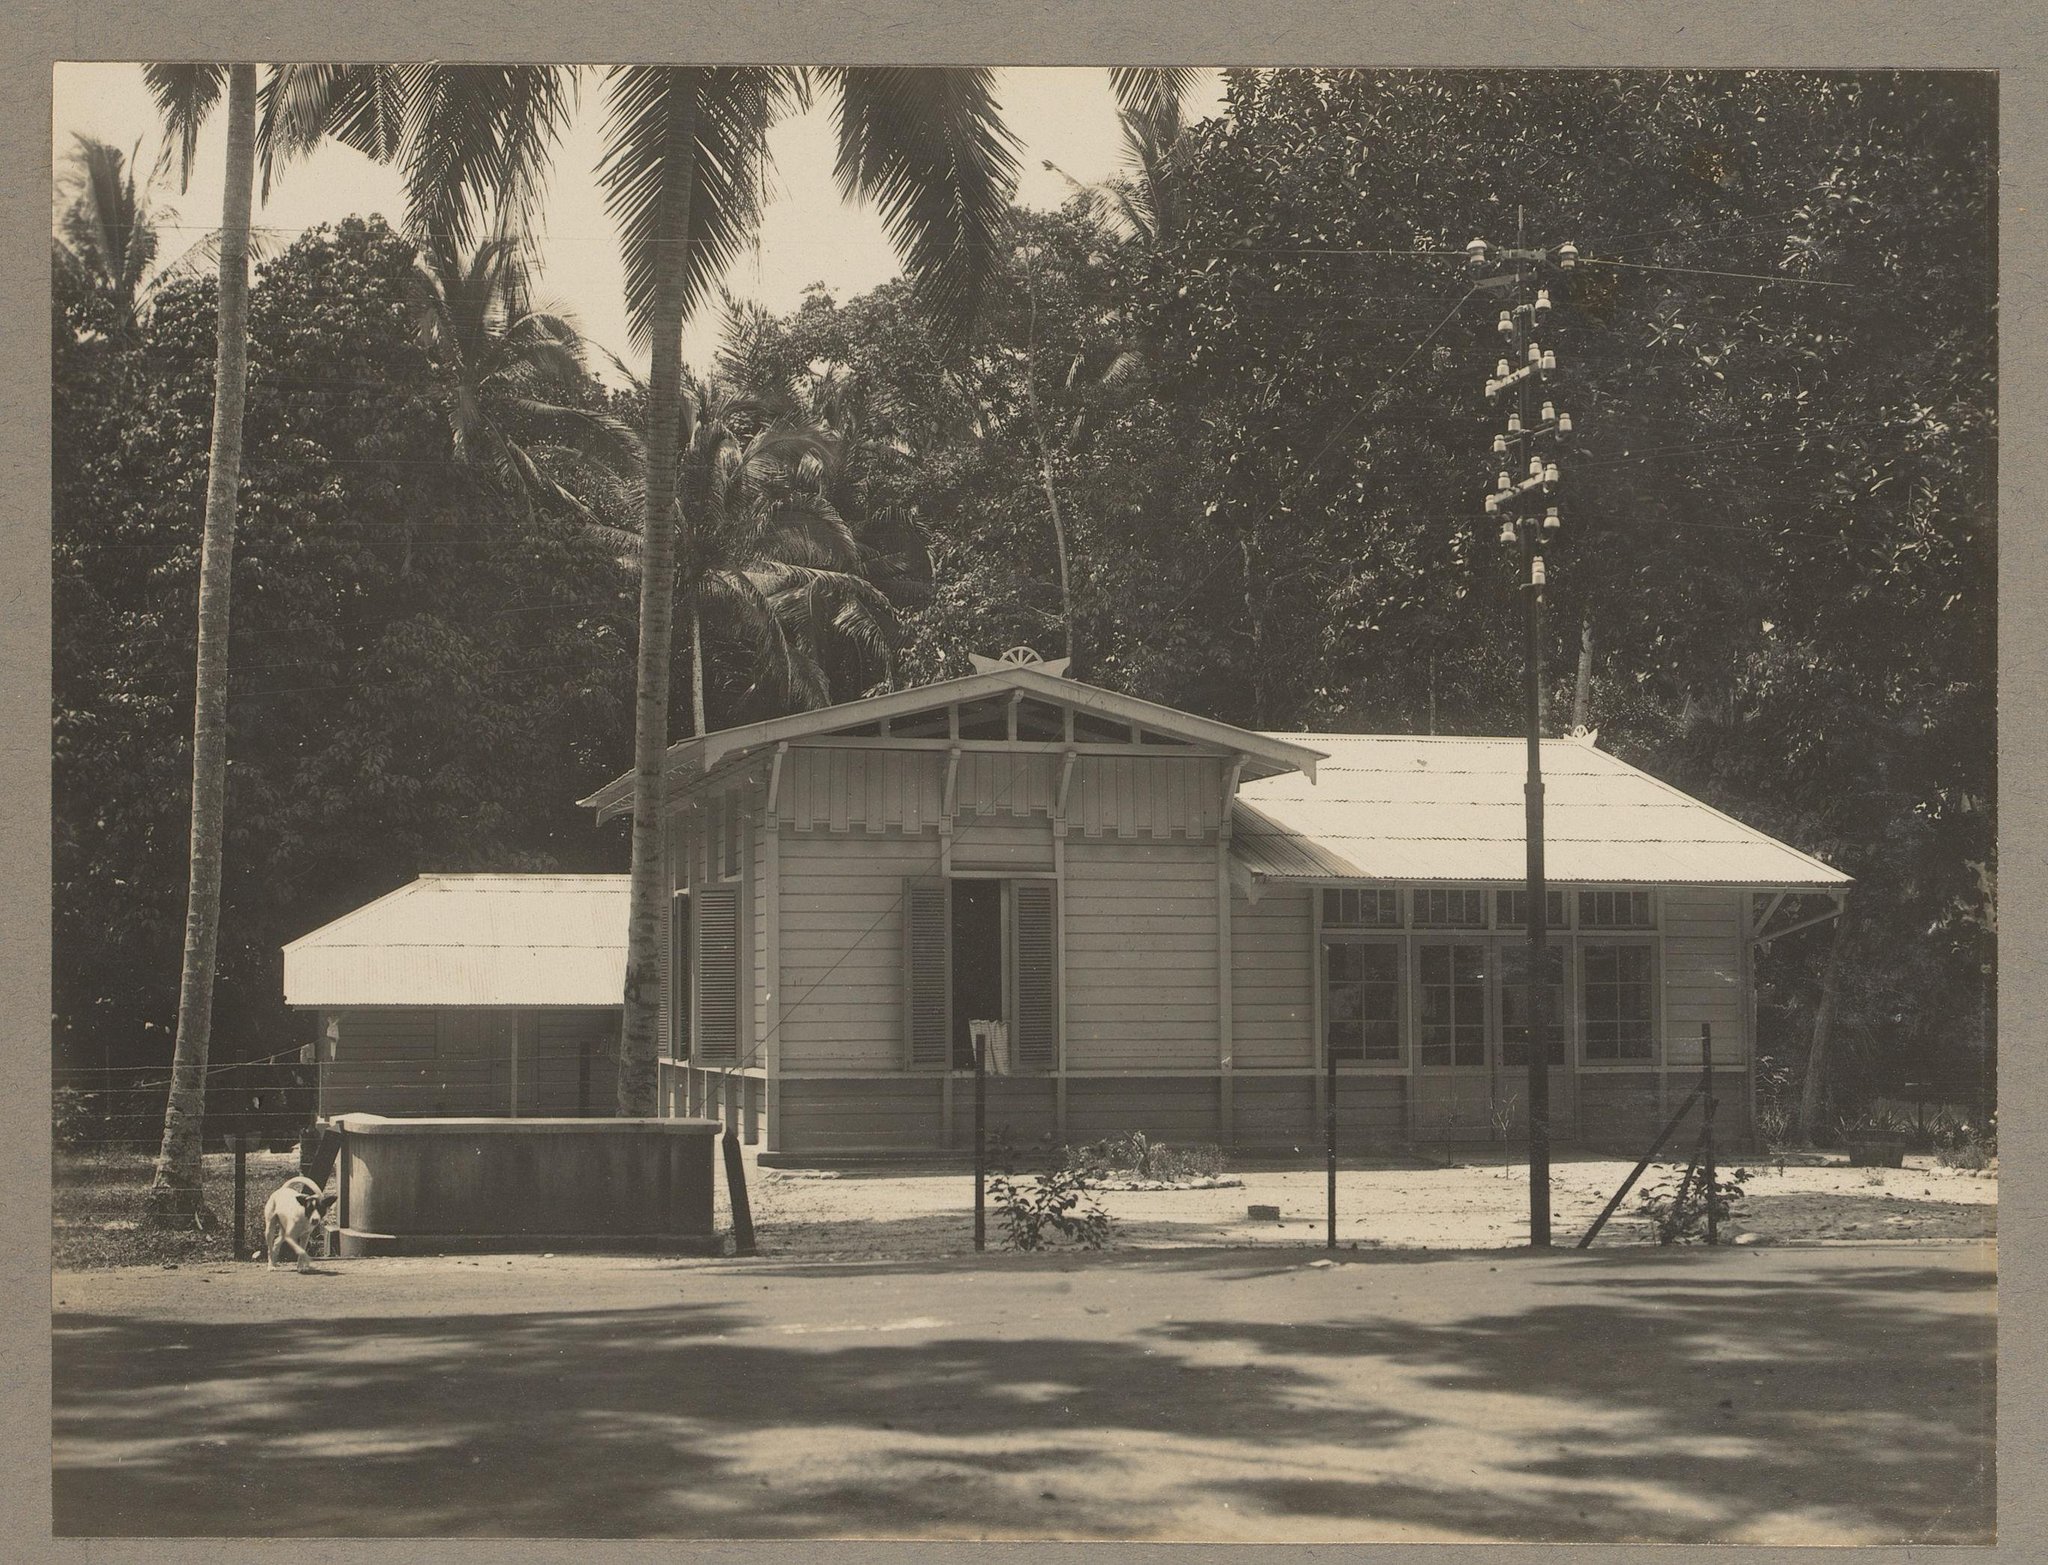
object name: photograph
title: Woning Postklerk Soengeiliat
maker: Anonymous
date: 1914-1919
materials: photographic support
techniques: gelatin silver print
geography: bangka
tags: robert julius boers, colonial system, mining, detached house in city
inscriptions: inscription: ‘Woning Postklerk Soengeiliat’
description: De woning van de postklerk van de Banka-tinwinning te Soengeiliat-Moerawang (Soengai Merawang). Onderdeel van het fotoalbum aangeboden aan Robert Julius Boers bij zijn vertrek naar Nederland in 1919 door het personeel van de Banka-tinwinning.